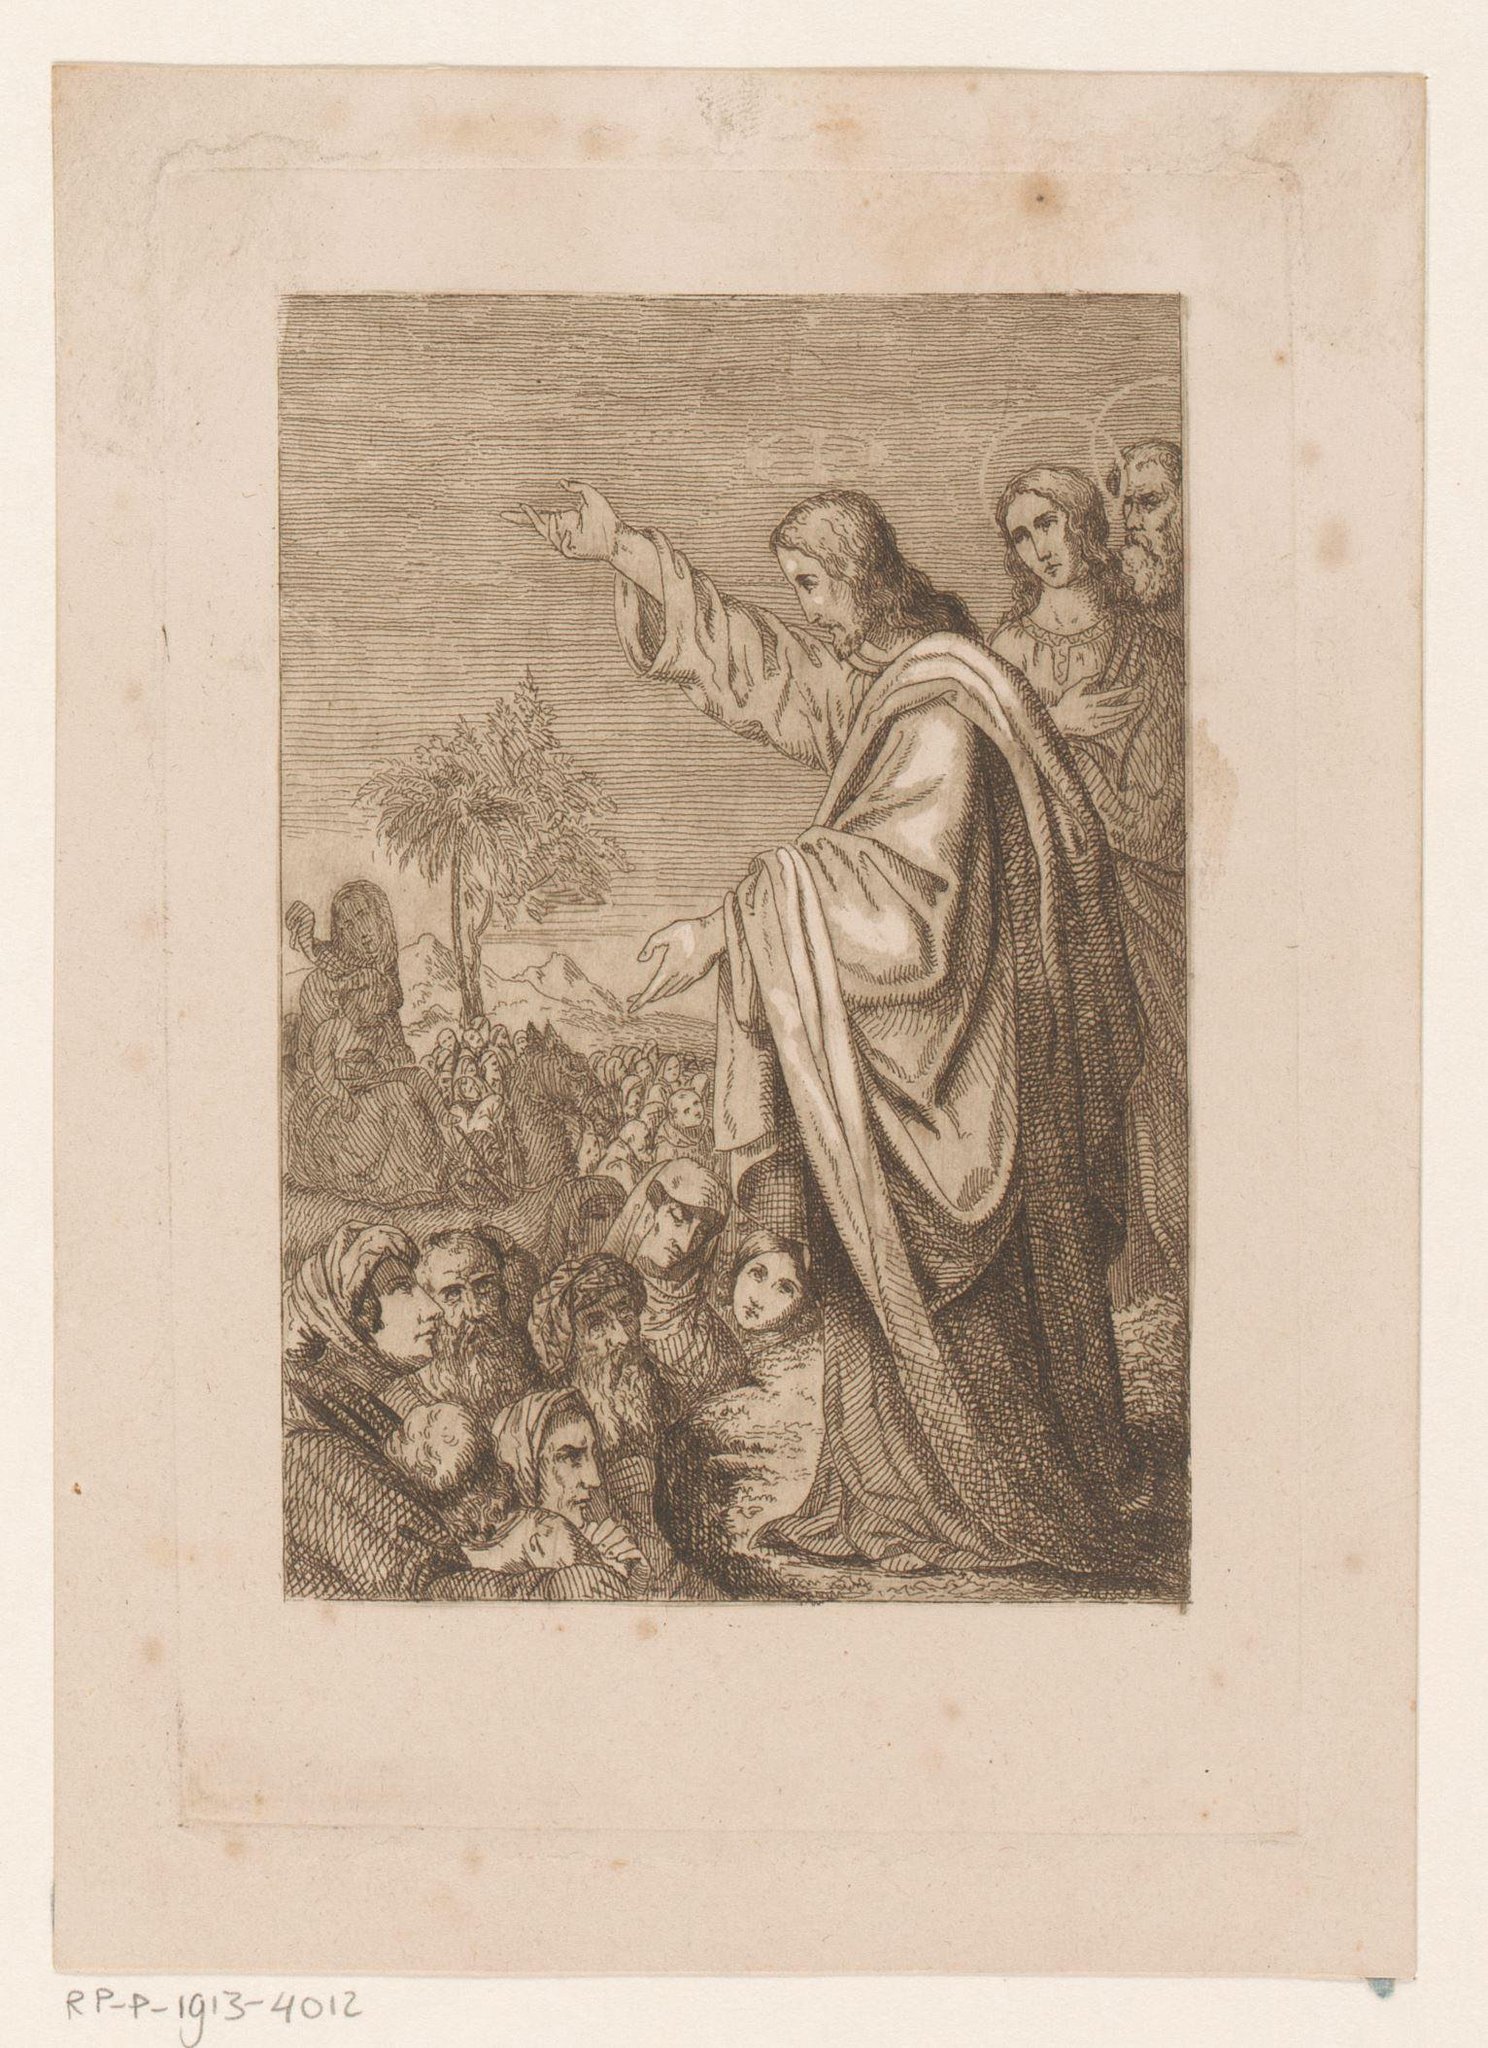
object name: print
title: Bergrede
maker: heinrich vianden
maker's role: painter, print maker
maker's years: 1814-1899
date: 1824-1899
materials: paper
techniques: etching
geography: germany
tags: christ's sermon on the mount (matthew 5-7)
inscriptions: collector's mark: Lugt 2228, collector's mark: Lugt 1485